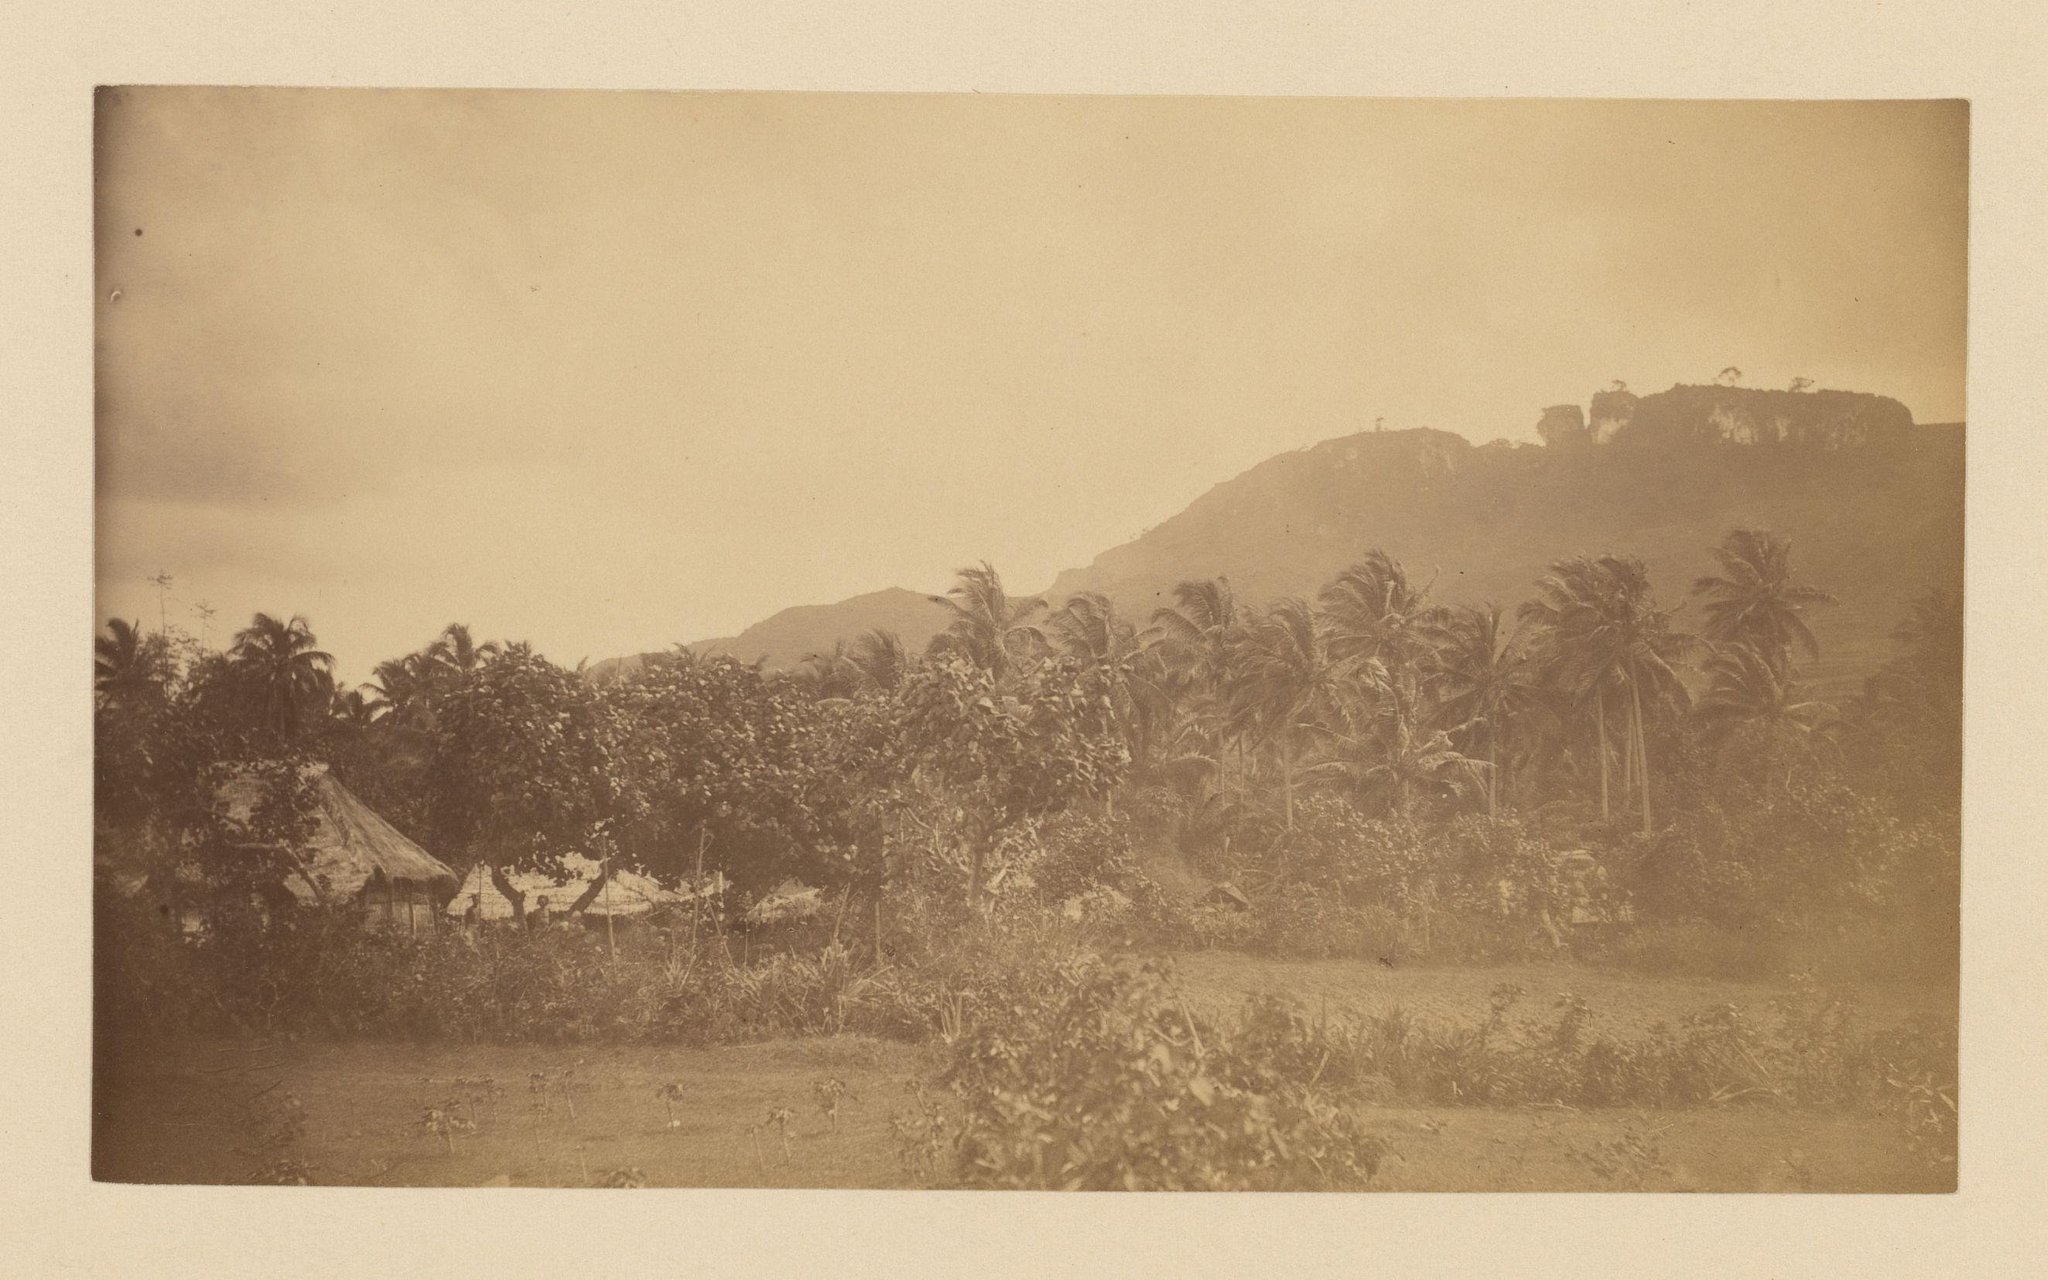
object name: photograph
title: Landschap op midden Java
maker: Anonymous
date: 1851-1900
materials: cardboard, paper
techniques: albumen print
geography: java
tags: landscapes in tropical and sub-tropical regions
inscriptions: inscription: ‘FOTO’